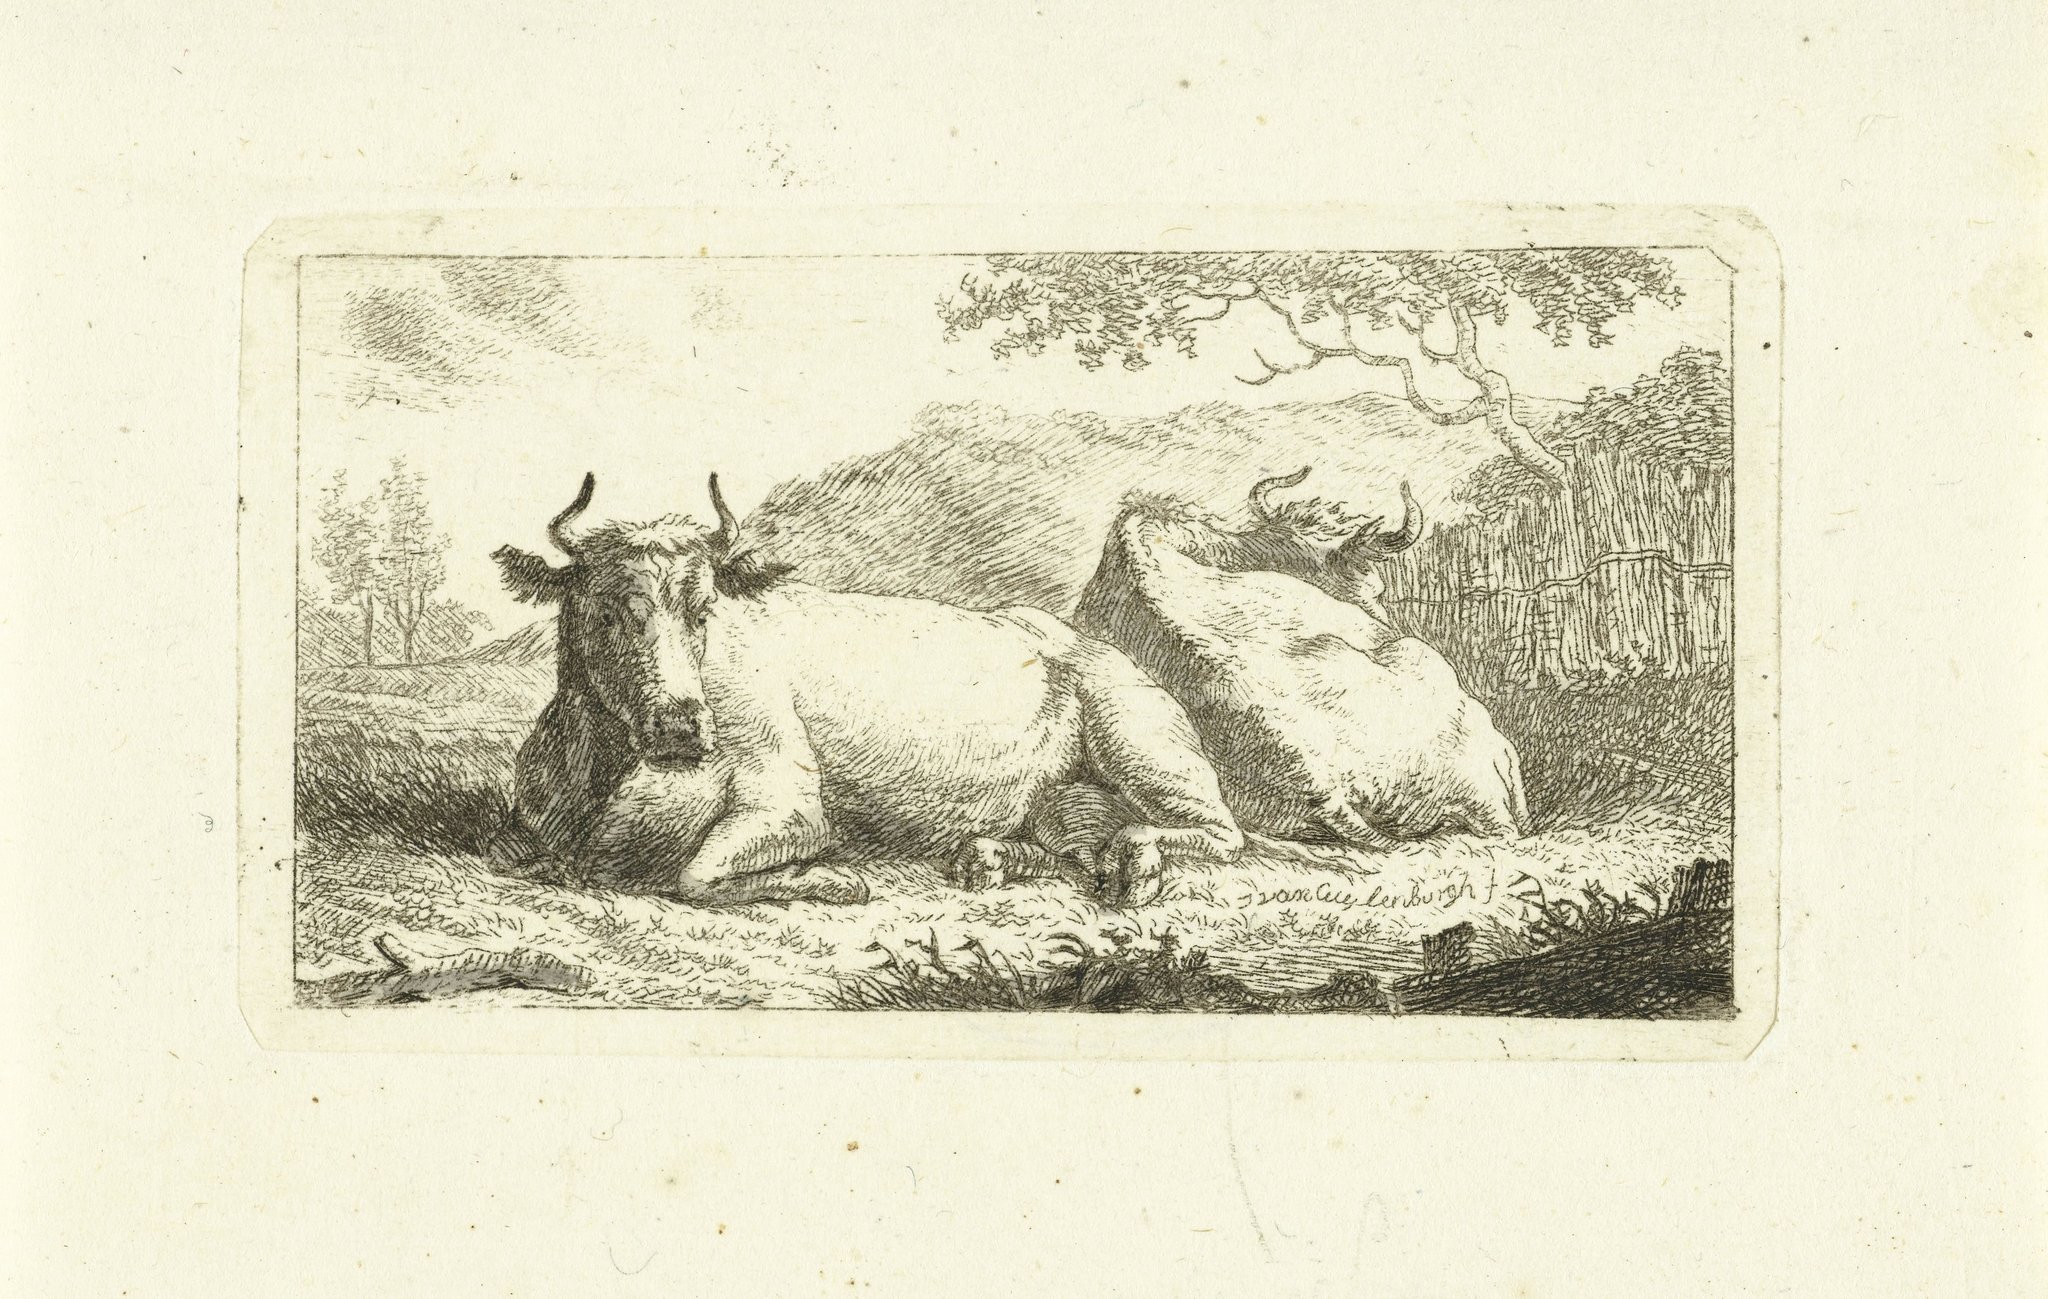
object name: print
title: Twee liggende koeien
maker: johannes van cuylenburgh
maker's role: print maker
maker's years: 1793-1841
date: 1803-1841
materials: paper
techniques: etching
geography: netherlands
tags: cow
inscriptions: collector's mark: Lugt 2228